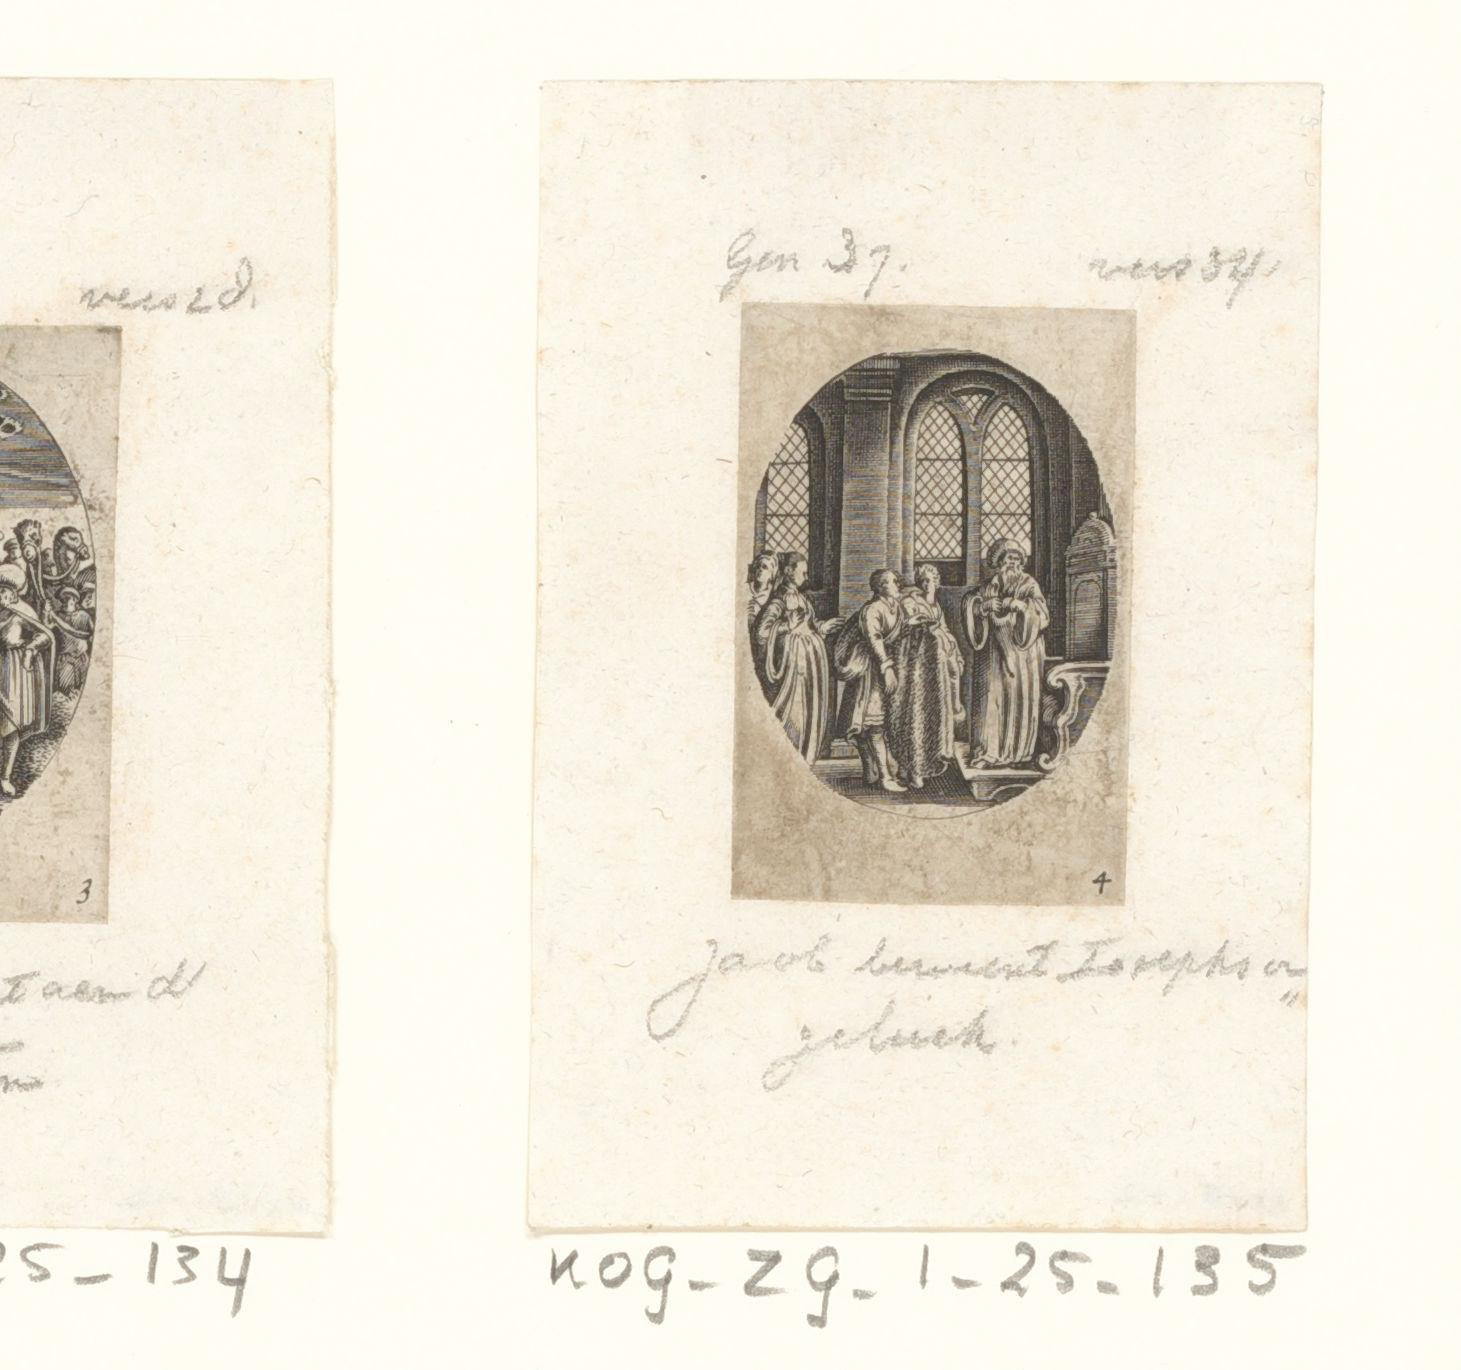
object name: print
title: Joseph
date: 1605-1652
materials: paper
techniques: engraving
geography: amsterdam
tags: story of joseph (part i), while joseph's brothers are eating, a caravan of ishmaelite (midianite) merchants passes by: judah proposes to sell joseph to them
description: Rechtsonder genummerd: 4. Onderwerpsrubrieken binnen de Atlas Zeden en Gewoonten: Zeden en Gewoonten in Engeren Zin, De Woning, Huisraad, Zilverwerk.